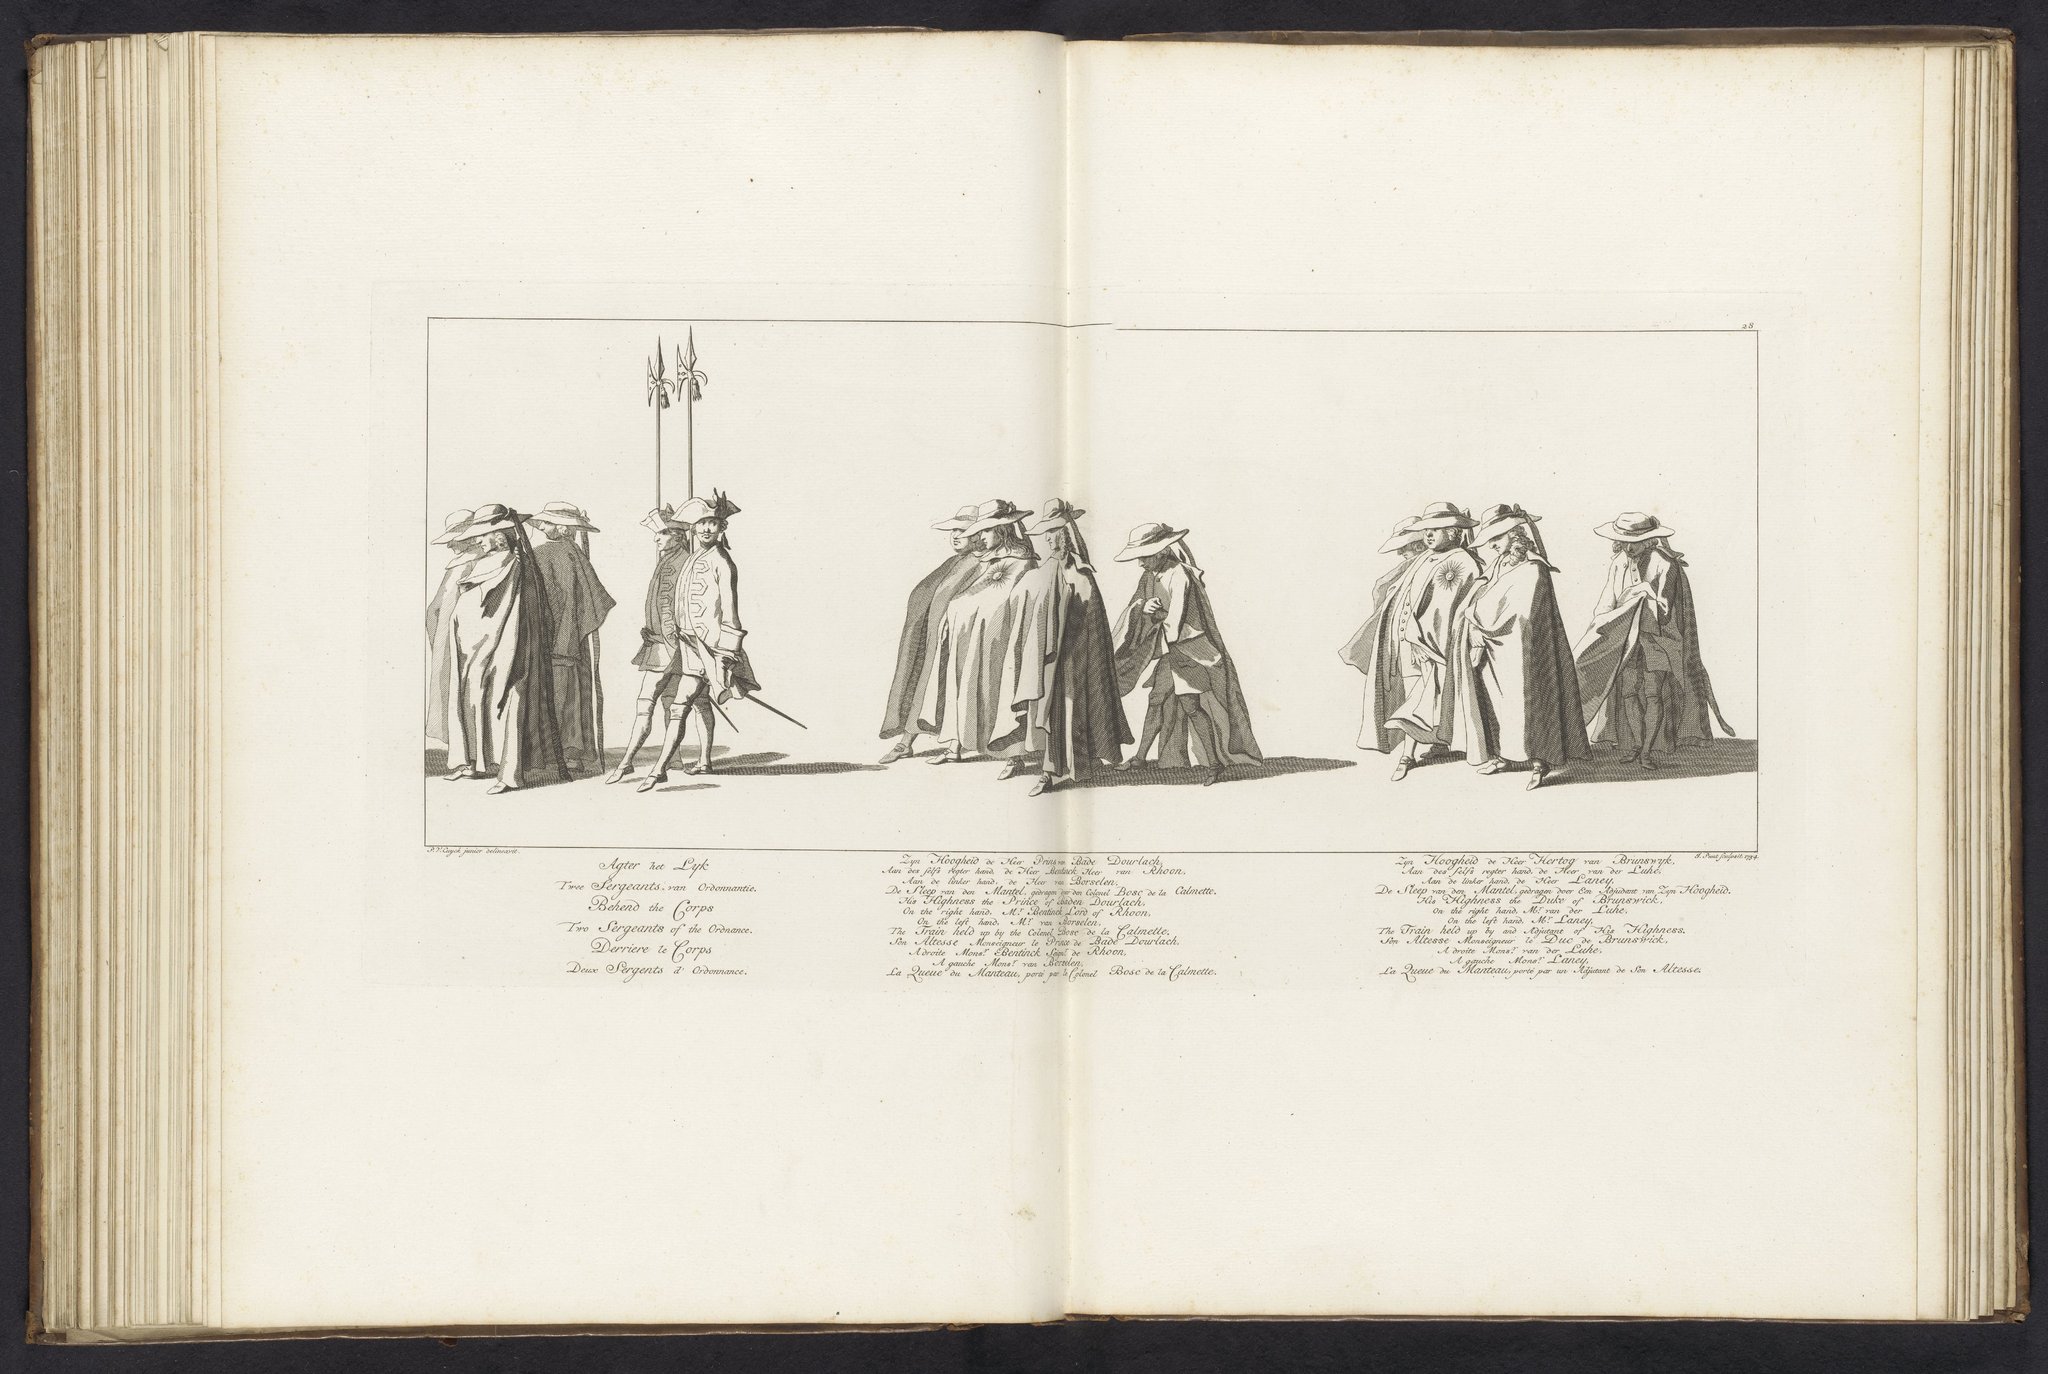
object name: print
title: Lyk-staetsie van zyne doorluchtigste Hoogheid den Heere Willem [IV] Carel Hendrik Friso, Prince van Orange en Nassau... gehouden den IV Februari 1752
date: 1754-1755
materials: paper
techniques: engraving, etching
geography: the hague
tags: the hague, willem iv (prins van oranje-nassau), cortege, funeral procession, delft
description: Adellijke gasten in de rouwstoet, voorafgegaan door twee sergeants. In de marge het onderschrift in Nederlands, Frans en Engels. Onderdeel van een serie van 41 platen van de begrafenisstoet van stadhouder Willem IV te Delft op 4 februari 1752. Genummerd rechtsboven: 28. In de gebonden uitgave van 1755.